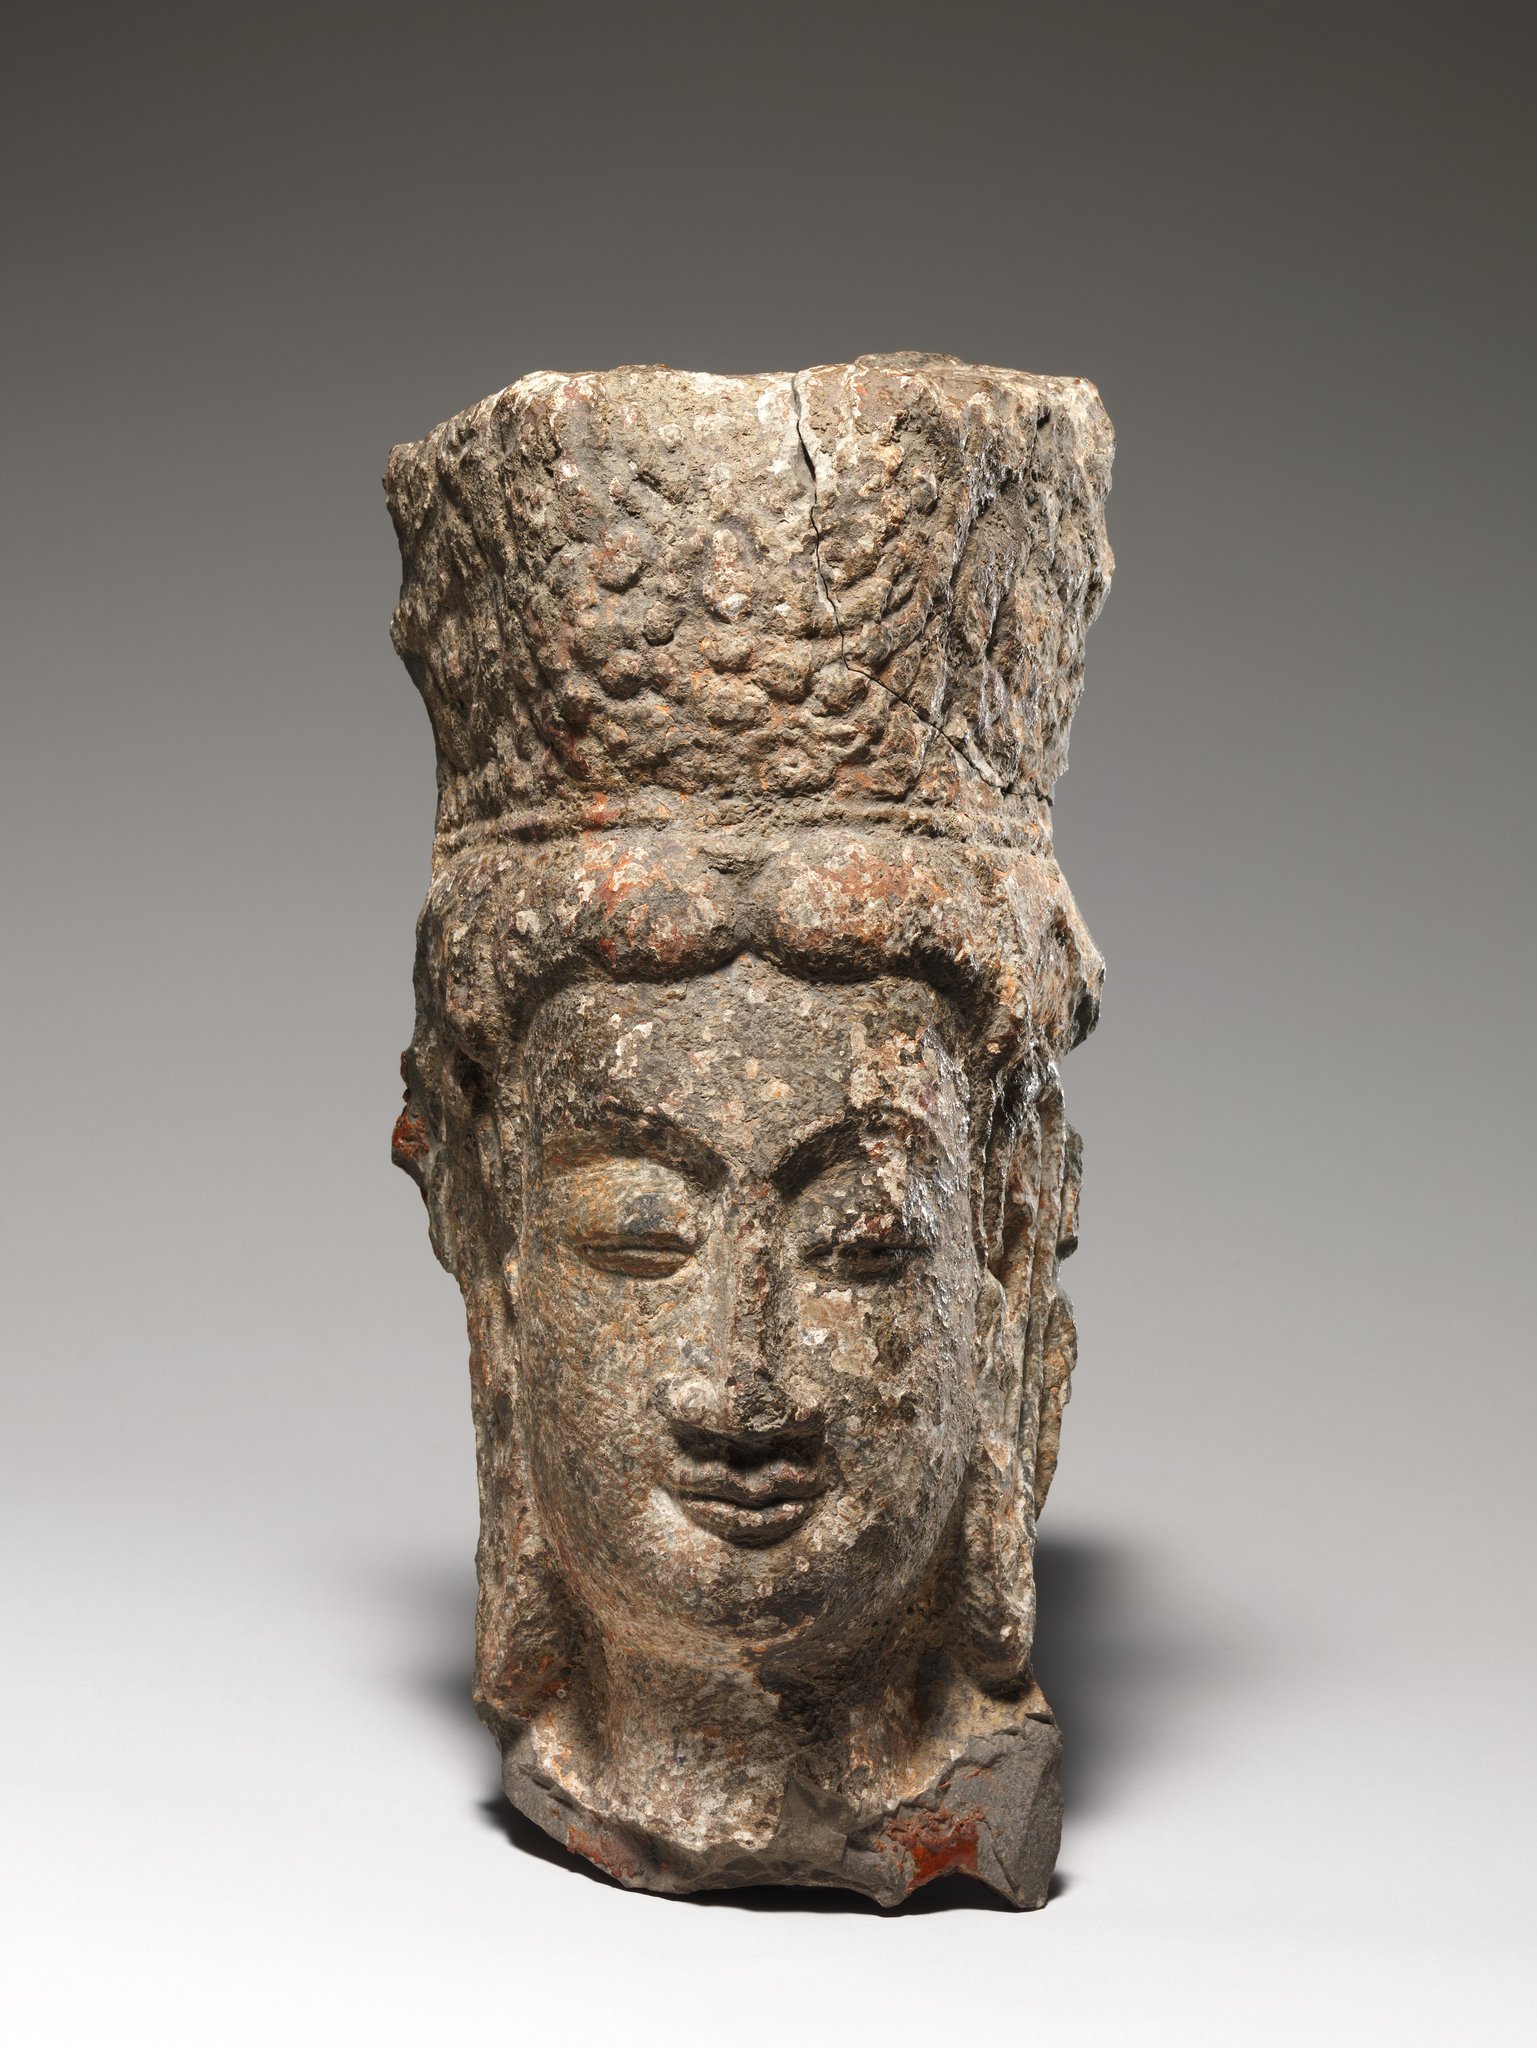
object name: head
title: Head of a bodhisattva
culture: chinese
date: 501-533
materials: limestone, marble